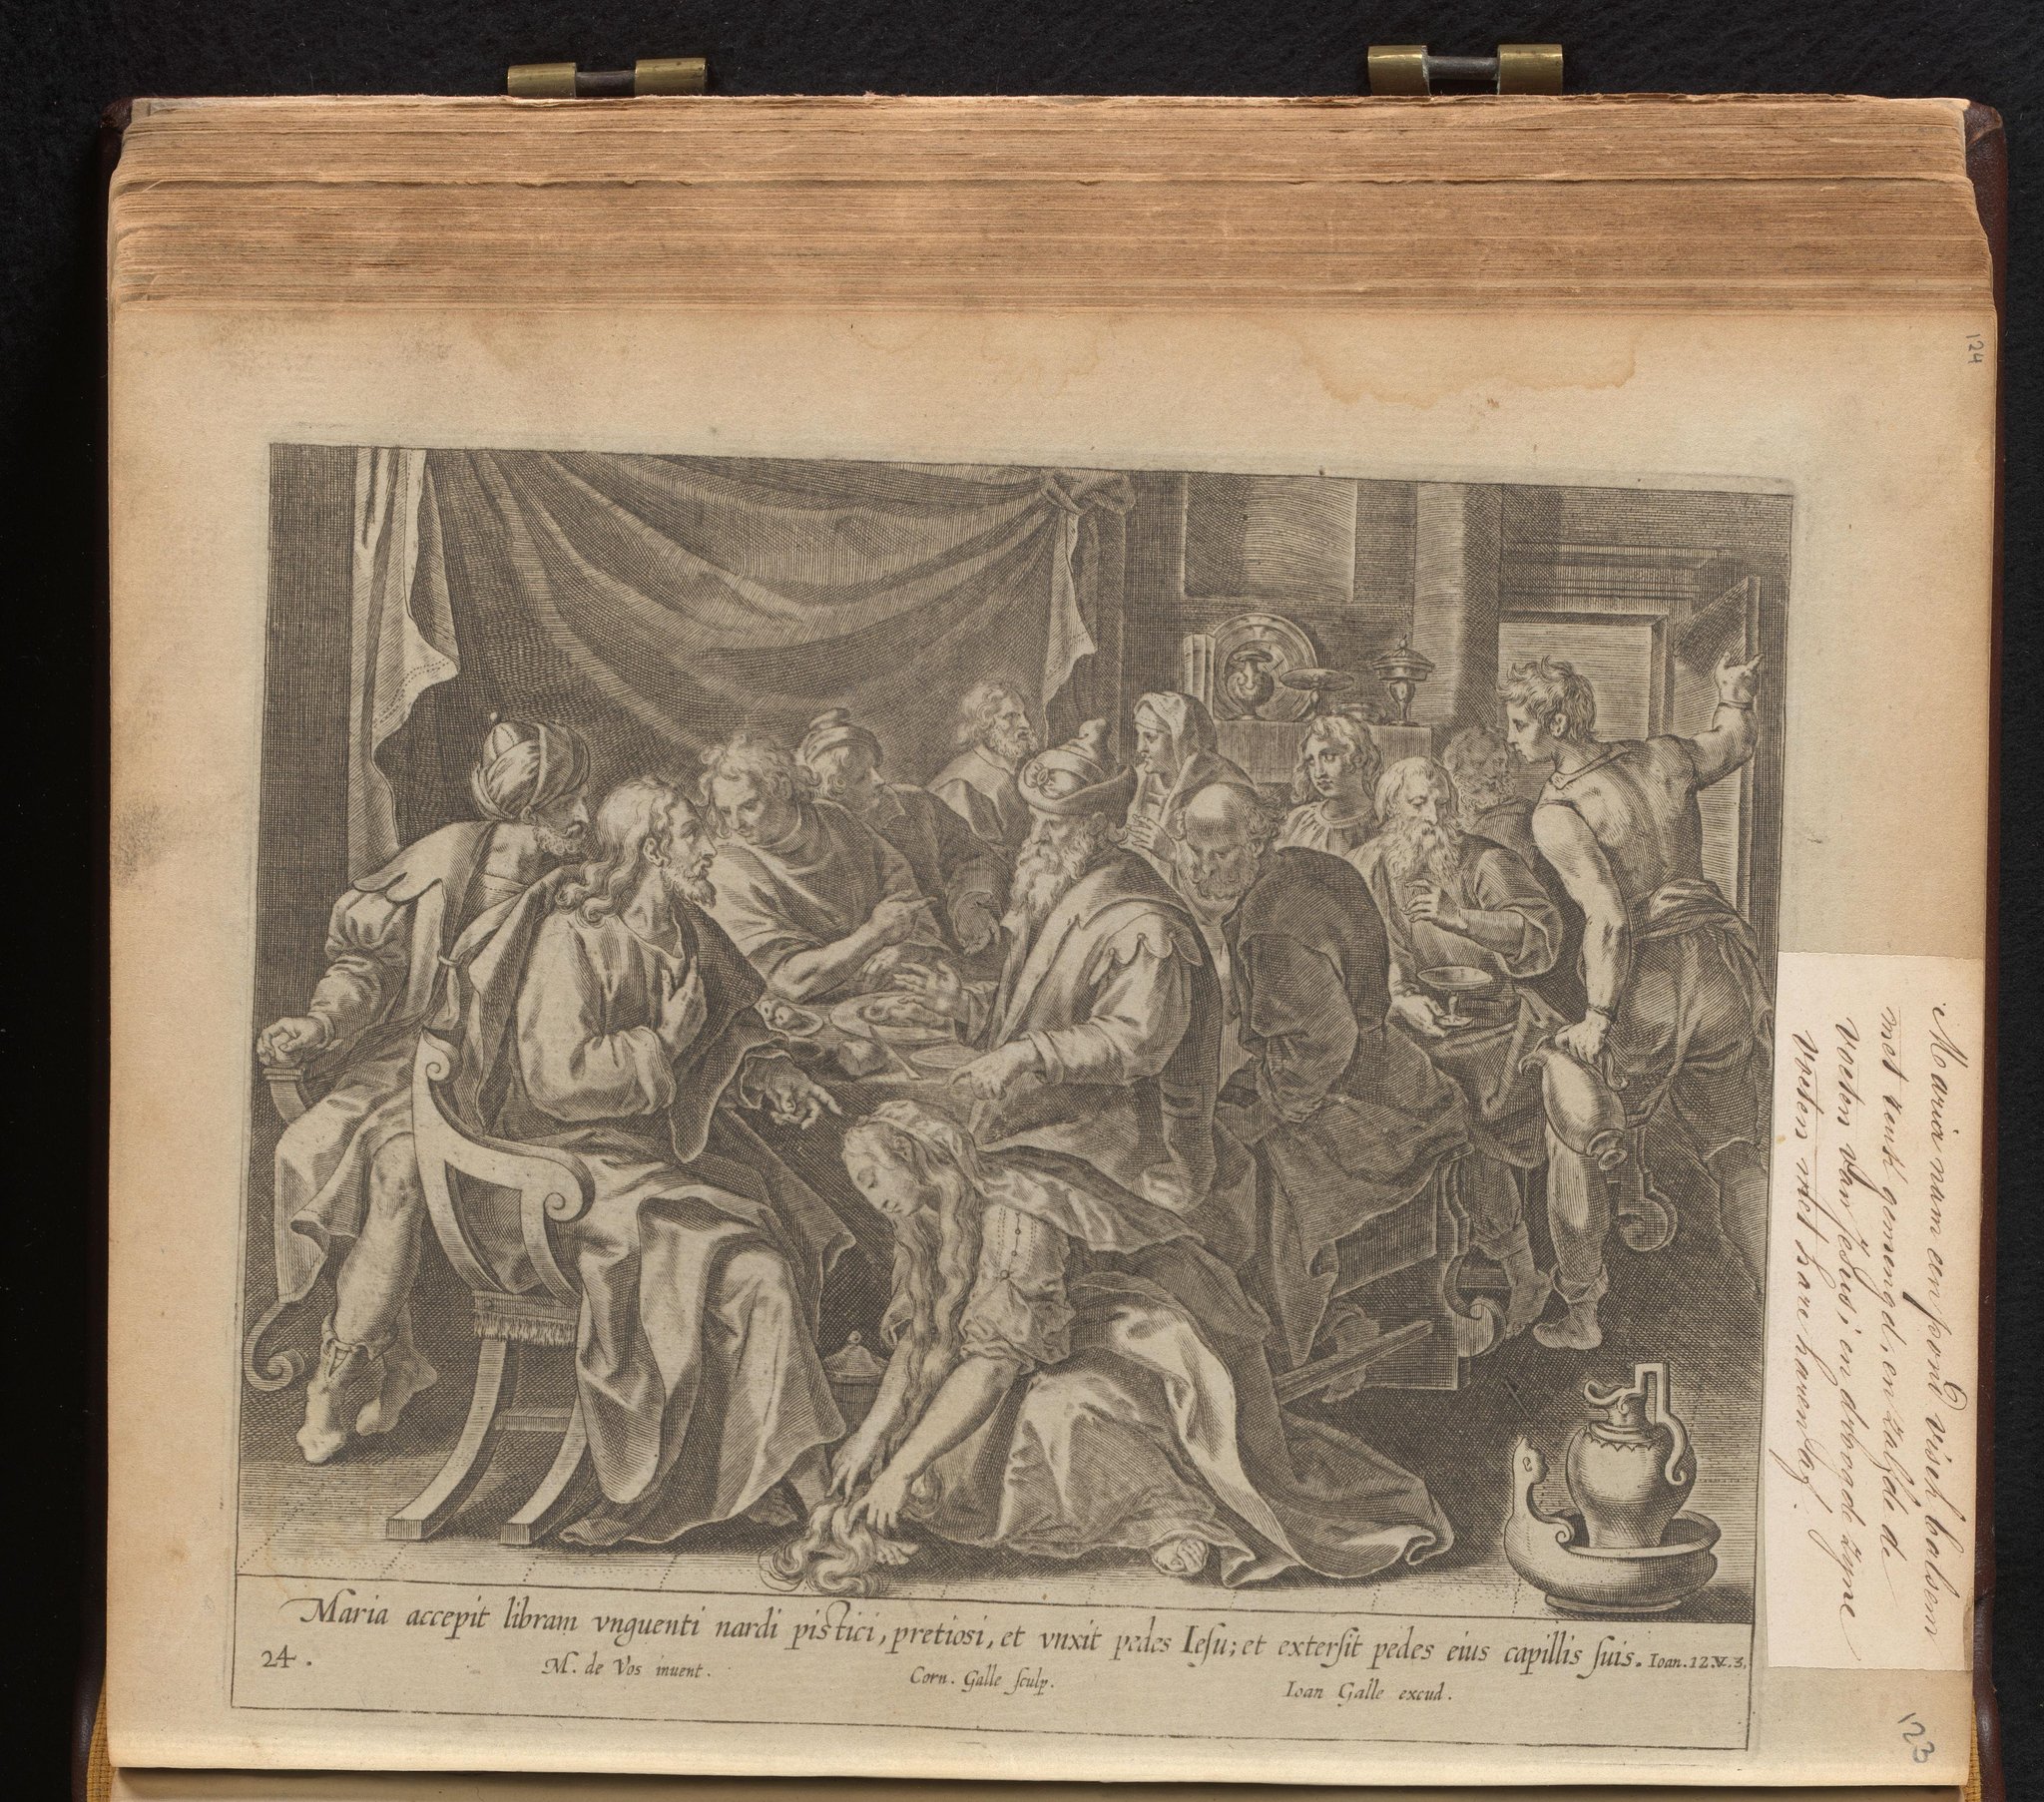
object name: album leaf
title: Leven, passie en wederopstanding van Christus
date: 1598-1618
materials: paper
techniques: engraving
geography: antwerp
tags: a woman washes christ's feet with her tears, and wipes them with her hair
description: Prent maakt deel uit van een prentbijbel.